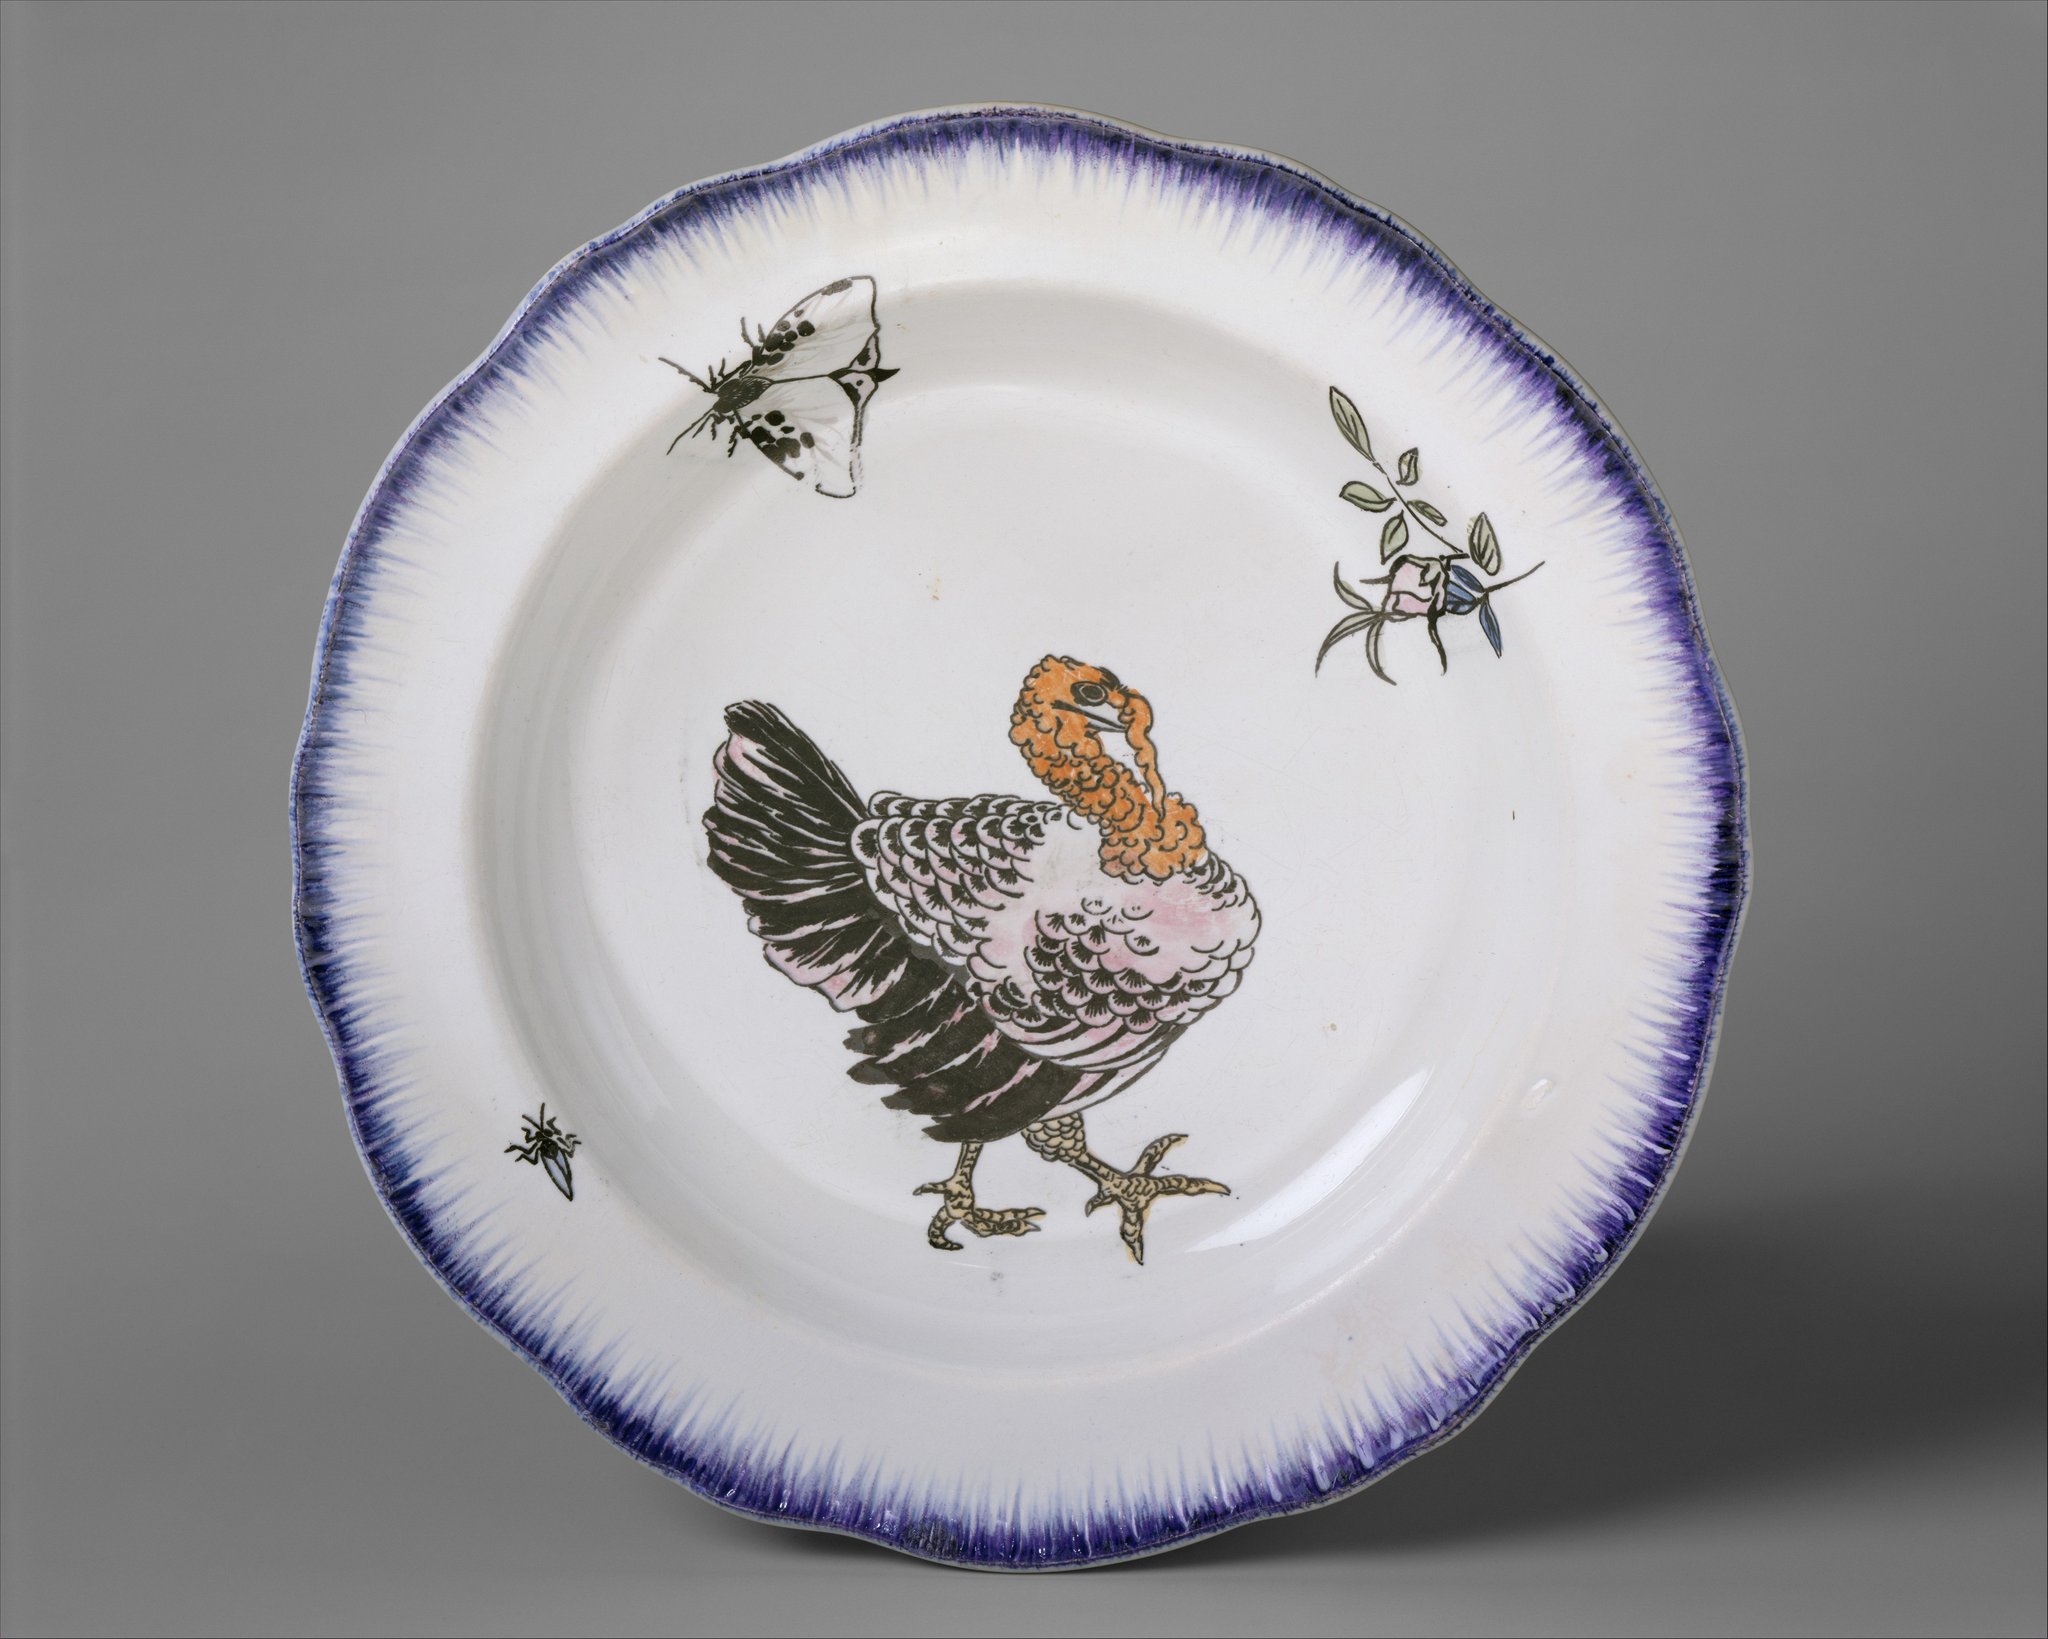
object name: soup plate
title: Soup plate (part of a set of three)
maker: félix bracquemond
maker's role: artist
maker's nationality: french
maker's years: 1833-1914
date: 1866-1875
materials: creamware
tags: birds,butterflies